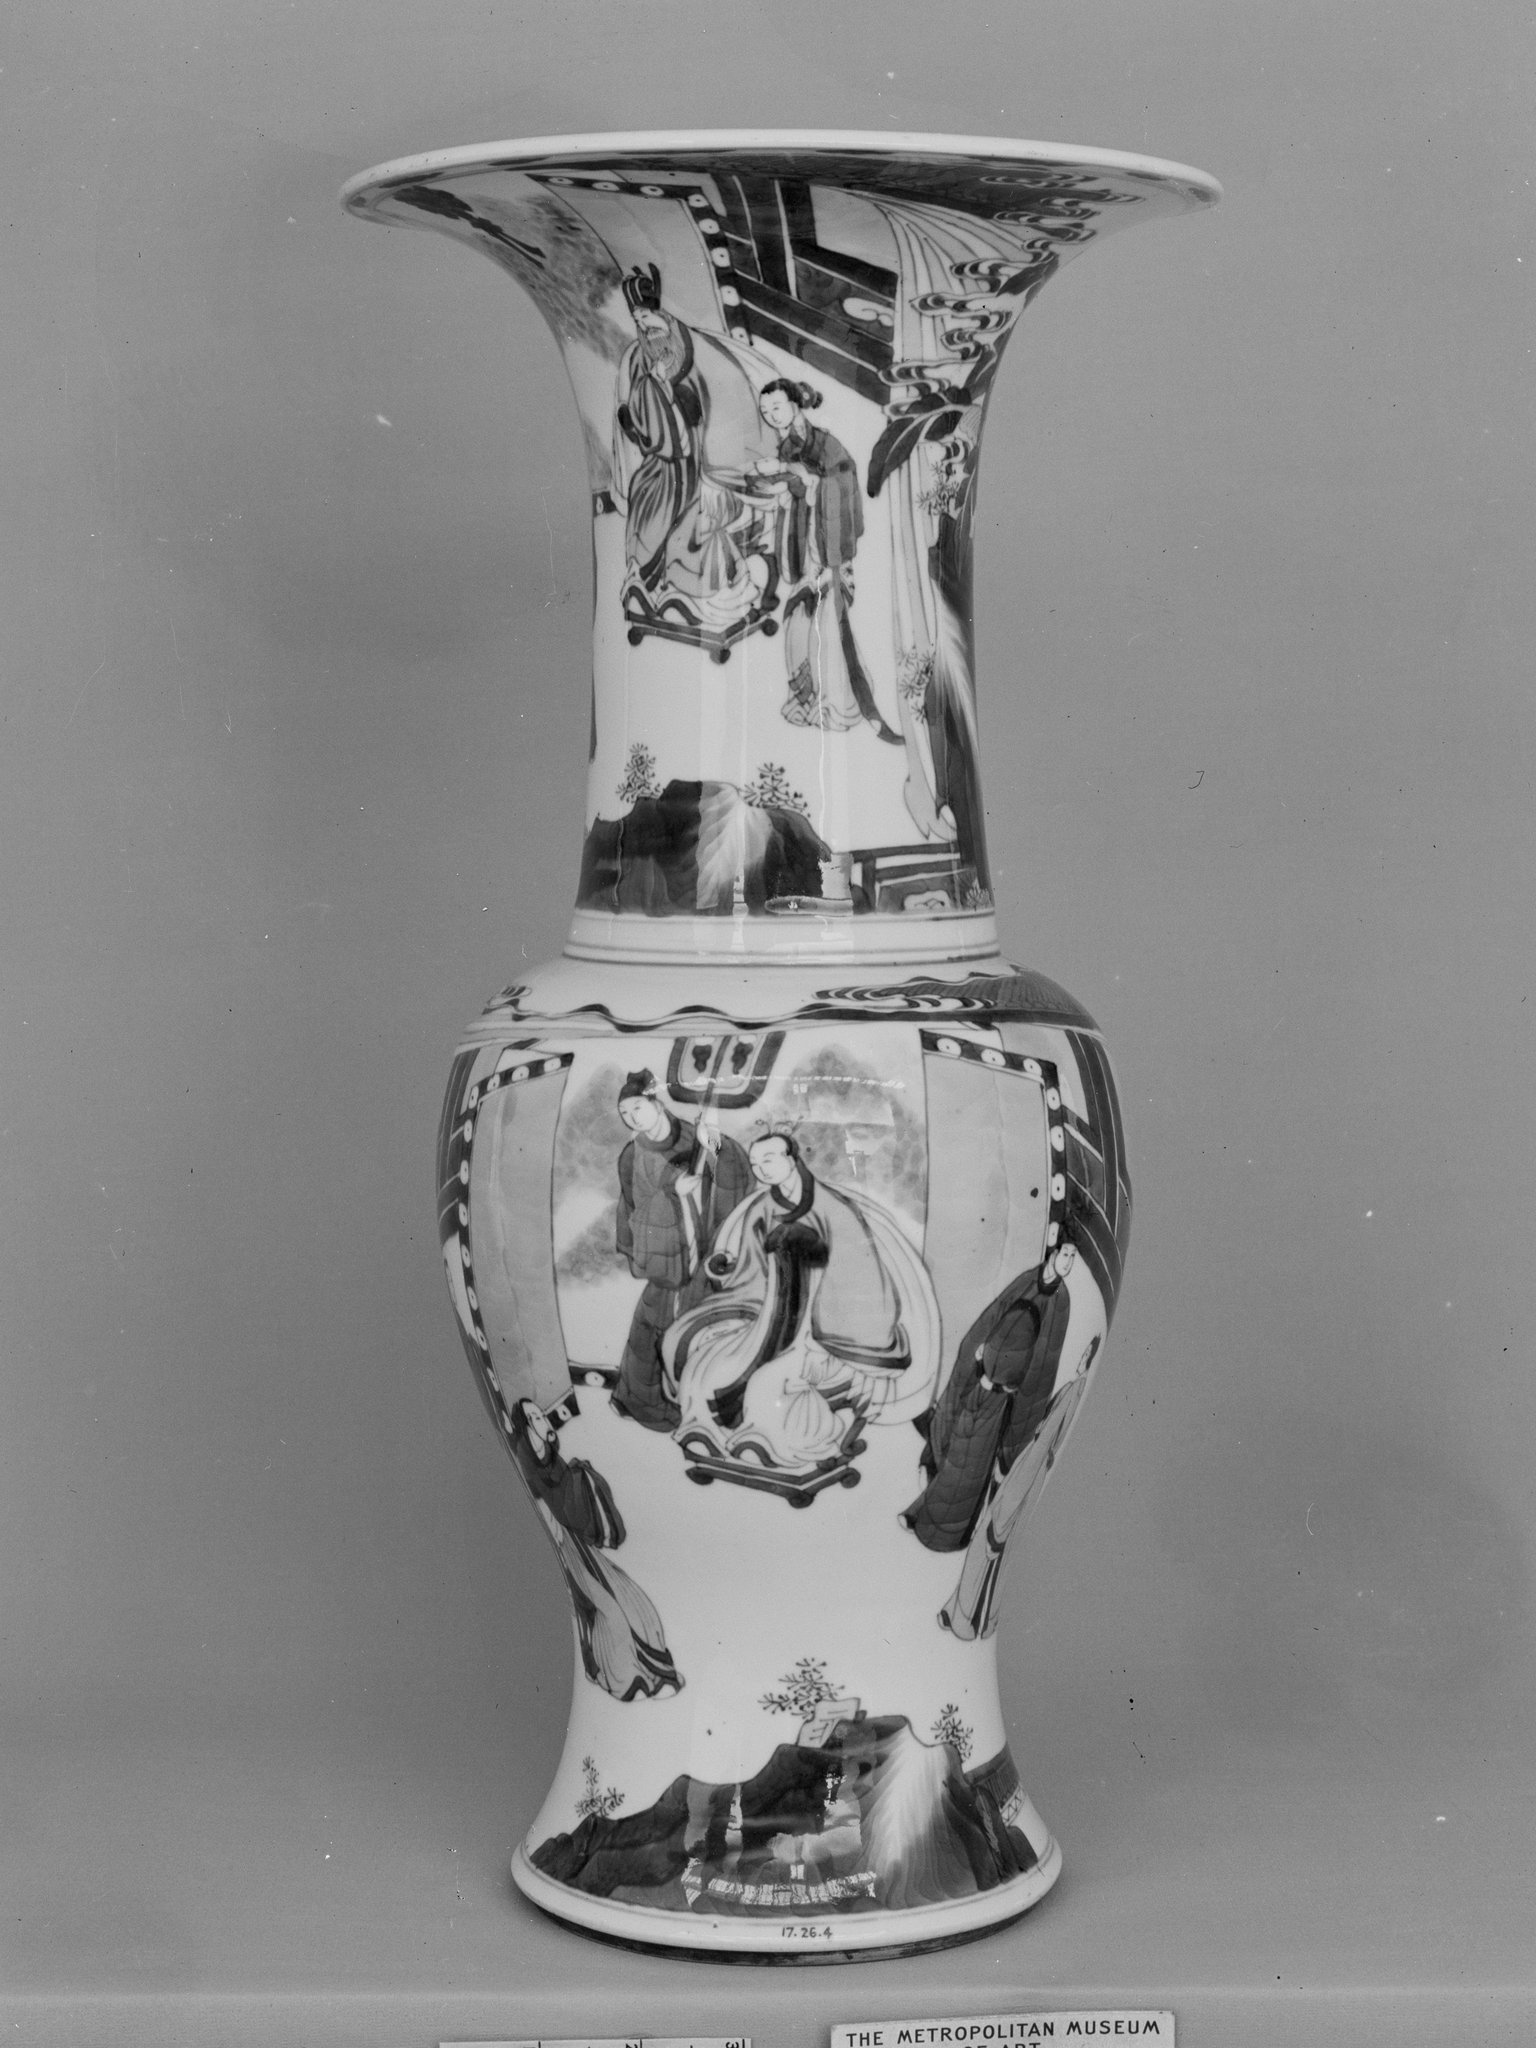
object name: jar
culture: chinese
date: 1662-1722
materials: porcelain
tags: men